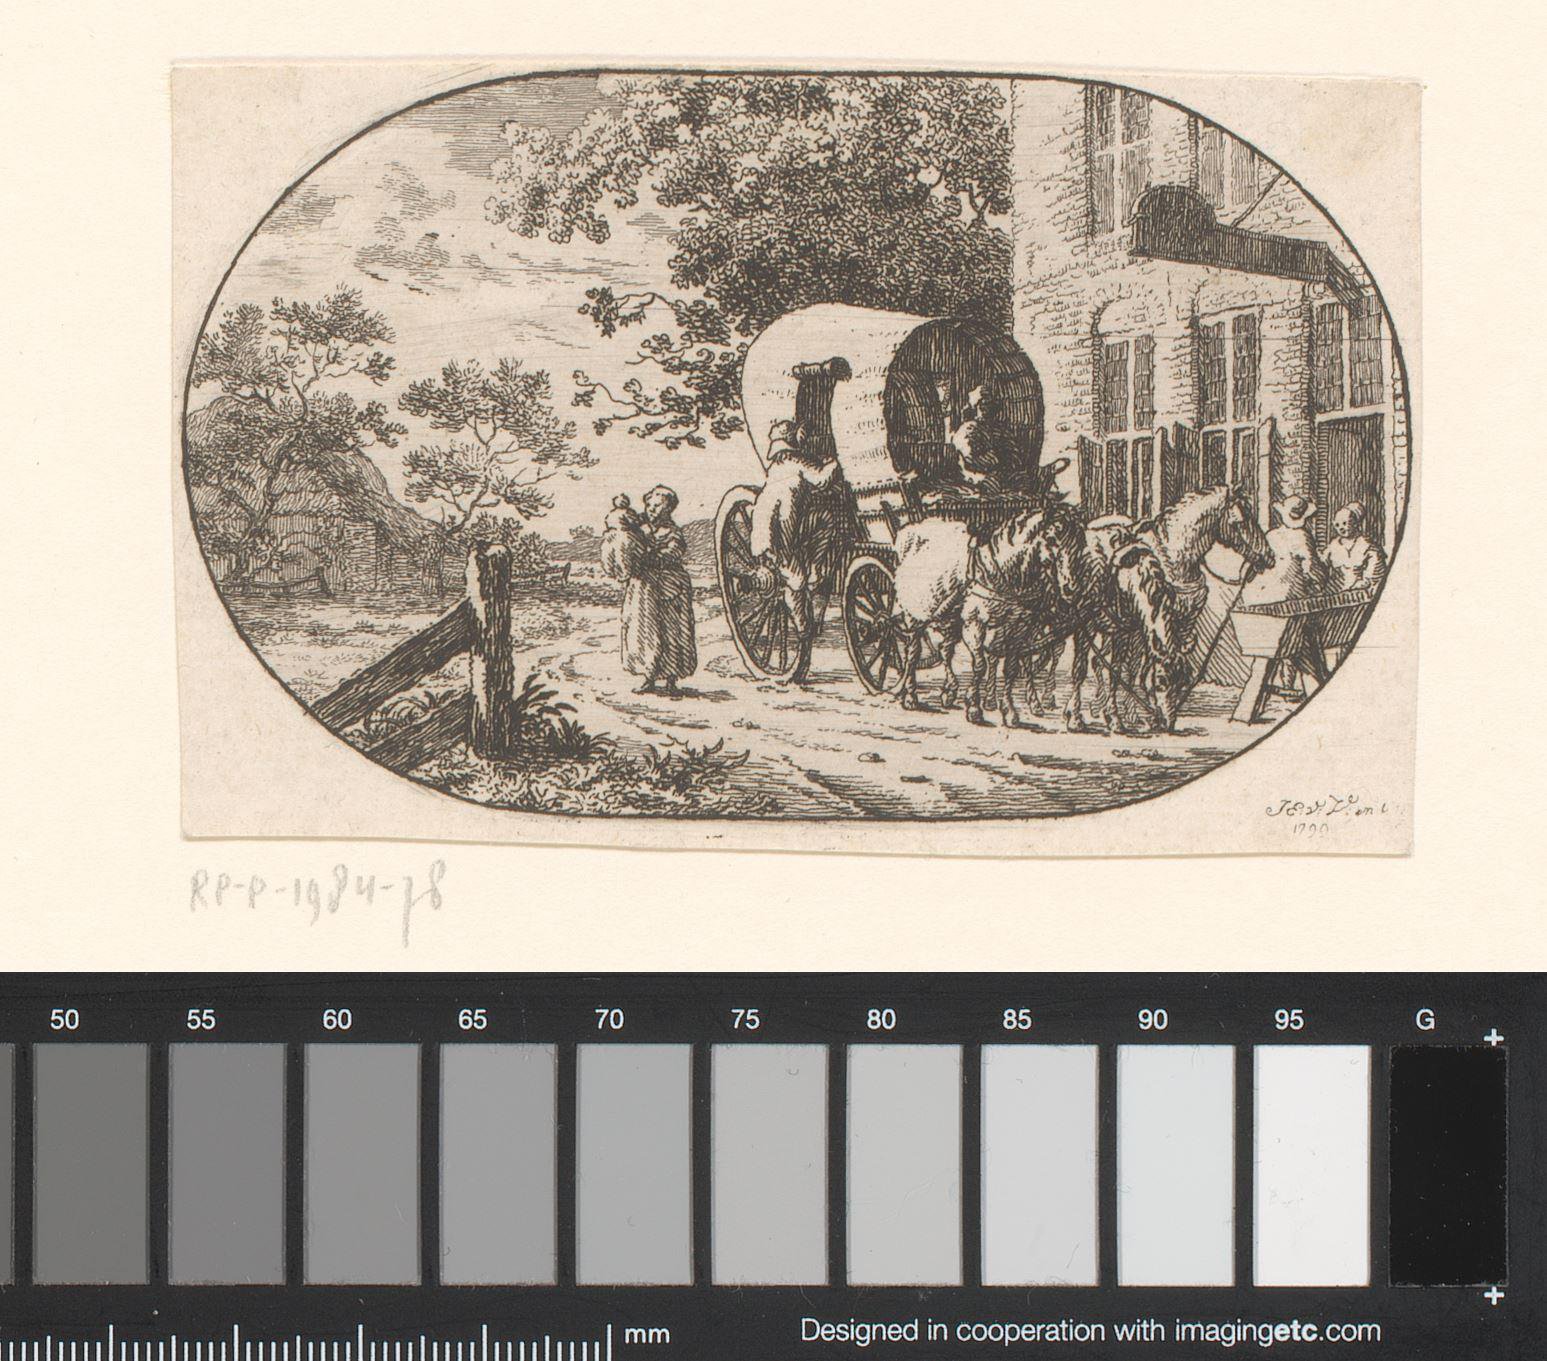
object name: print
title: Koets voor een herberg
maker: jacob elias van varelen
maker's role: draughtsman, print maker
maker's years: 1757-1840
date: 1799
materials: paper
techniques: etching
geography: haarlem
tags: four-wheeled vehicle drawn by three animals, hotel, hostelry, inn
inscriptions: collector's mark: Lugt 2228